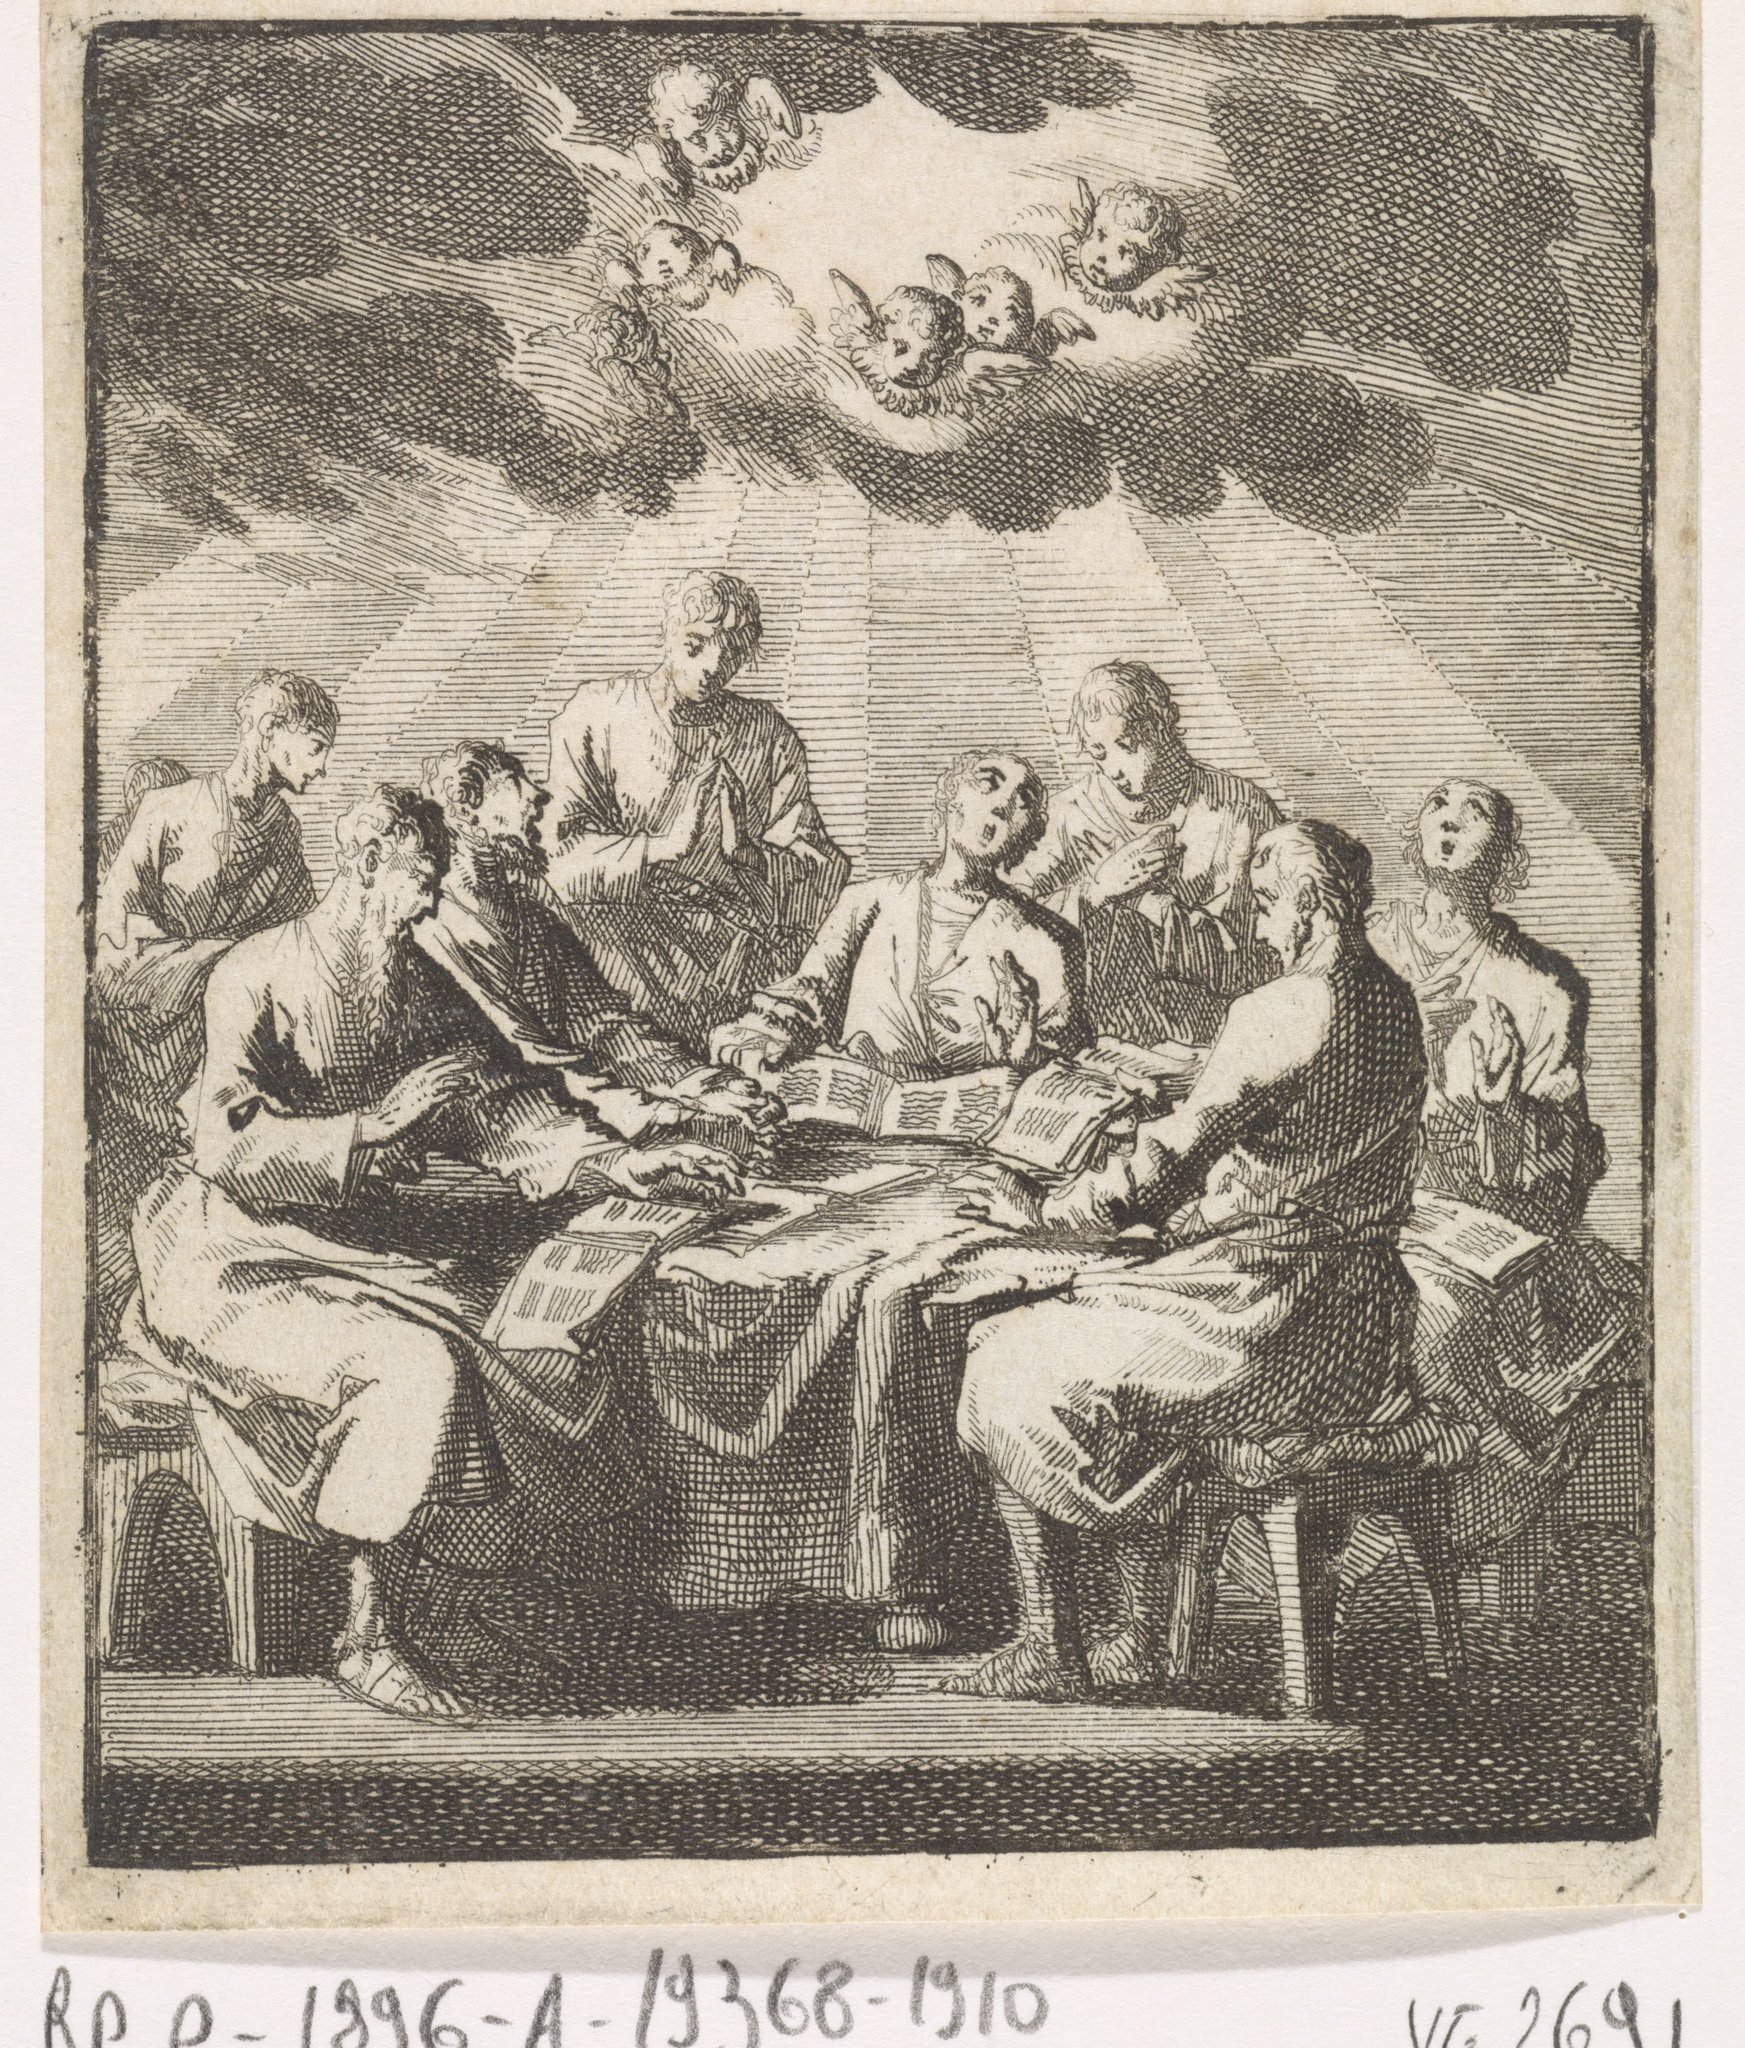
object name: book illustration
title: Acht zingende mannen rond een tafel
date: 1700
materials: paper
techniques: etching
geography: amsterdam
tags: singing of psalms, hymns, etc., cherubs, i.e. children's heads with wings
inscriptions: collector's mark: Lugt 2228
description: Boekillustratie voor Jan Huygen. Stichtelyke rymen op verscheiden stoffen. Amsterdam: Gedrukt door Jacobus van Herdenberg voor Jan Huygen, 1700, p. 1.